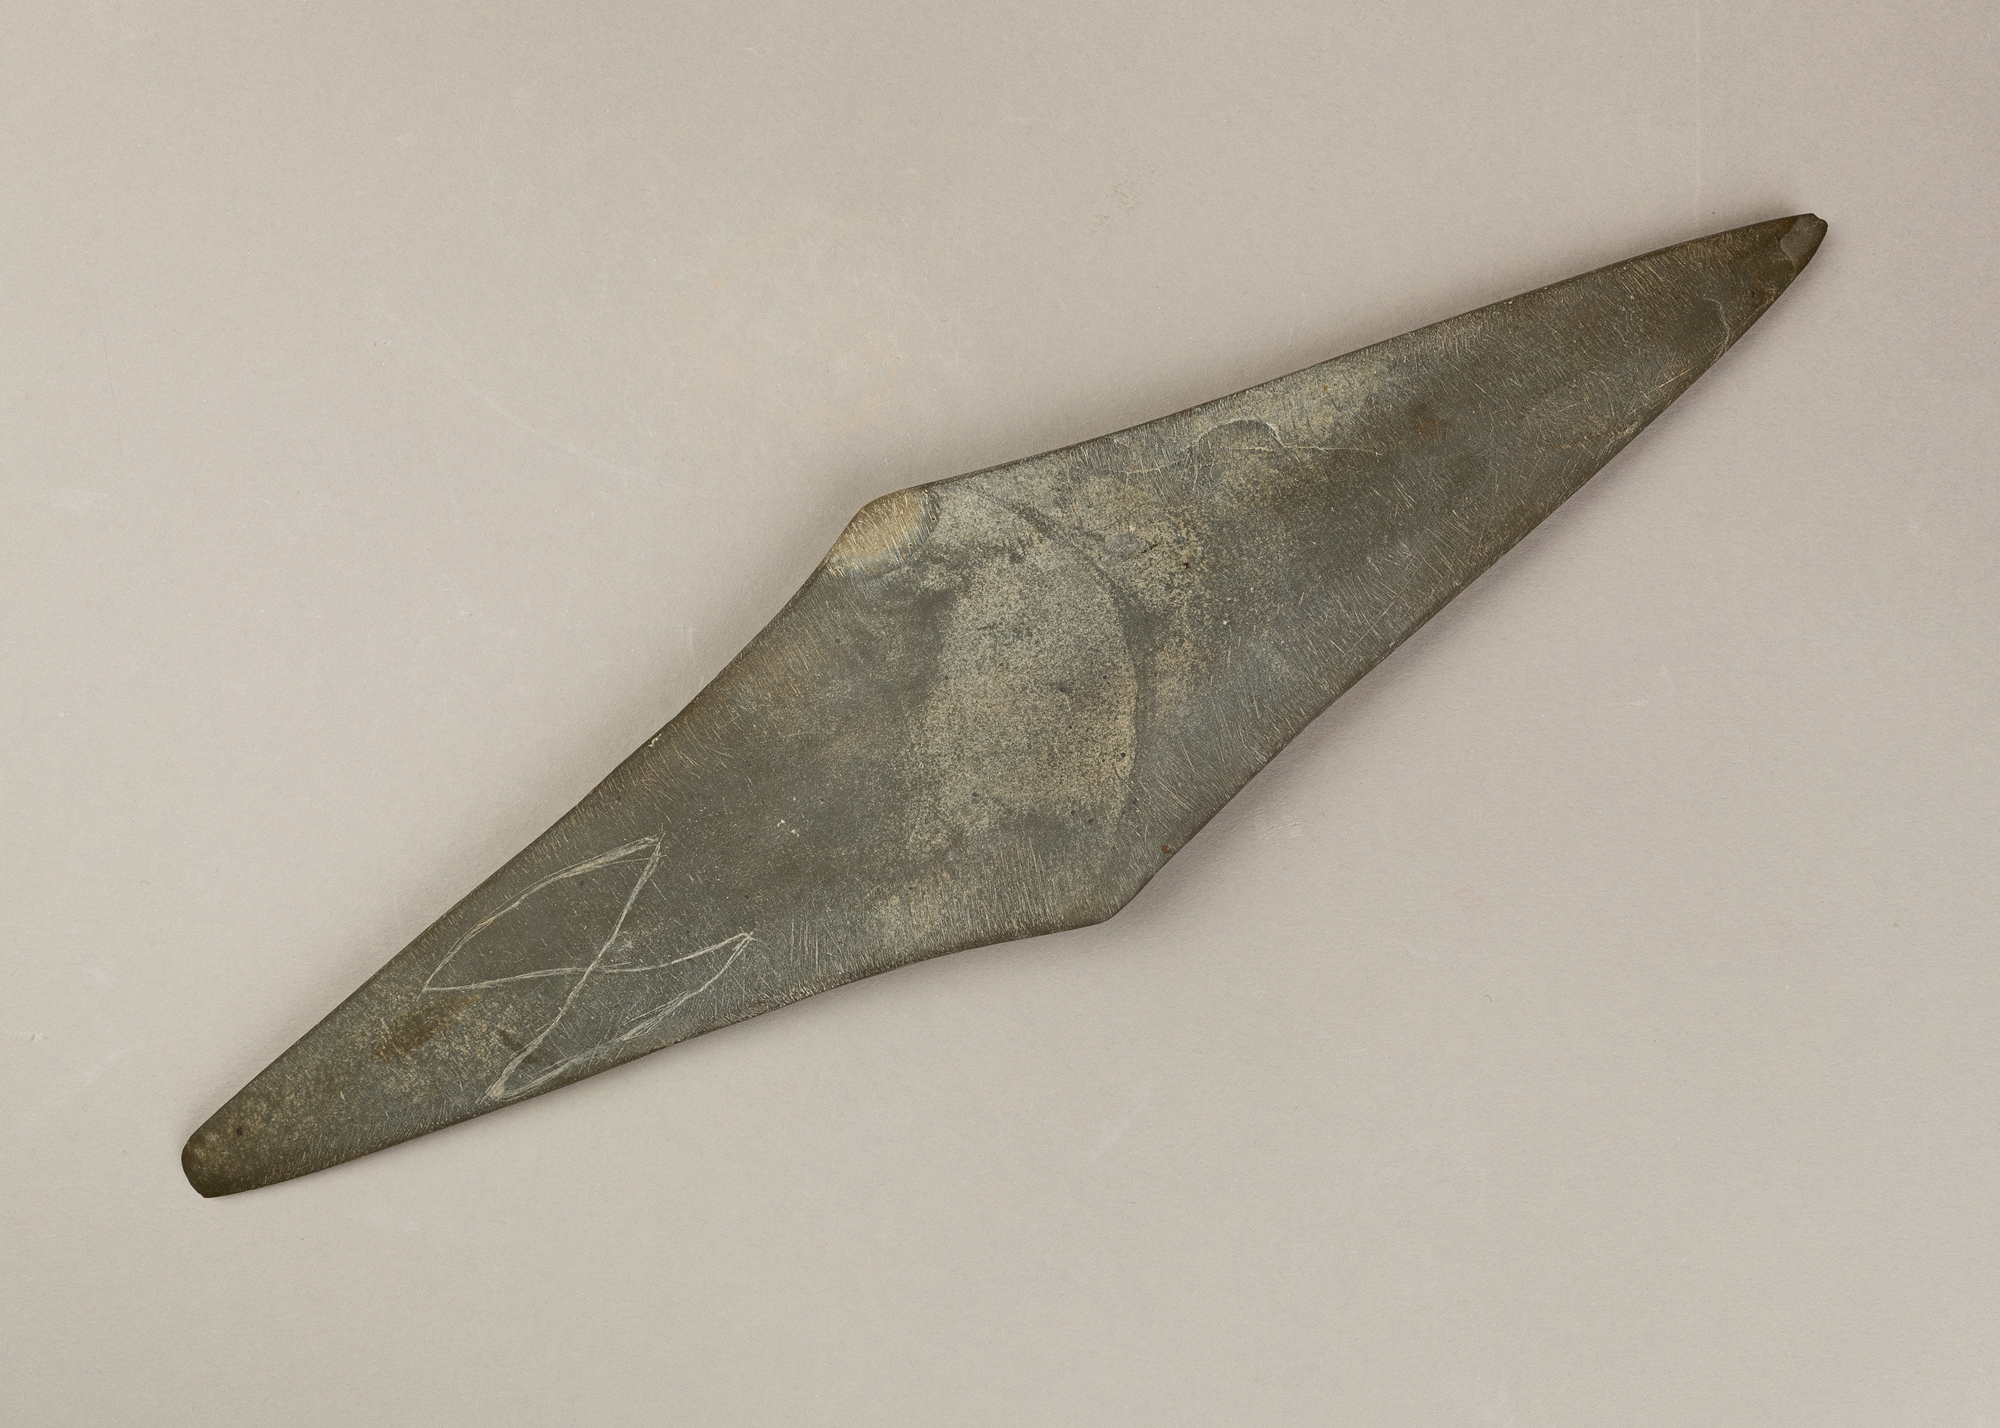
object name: palette, rhomboid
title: Rhomboidal palette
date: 3850-2960 BCE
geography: egypt